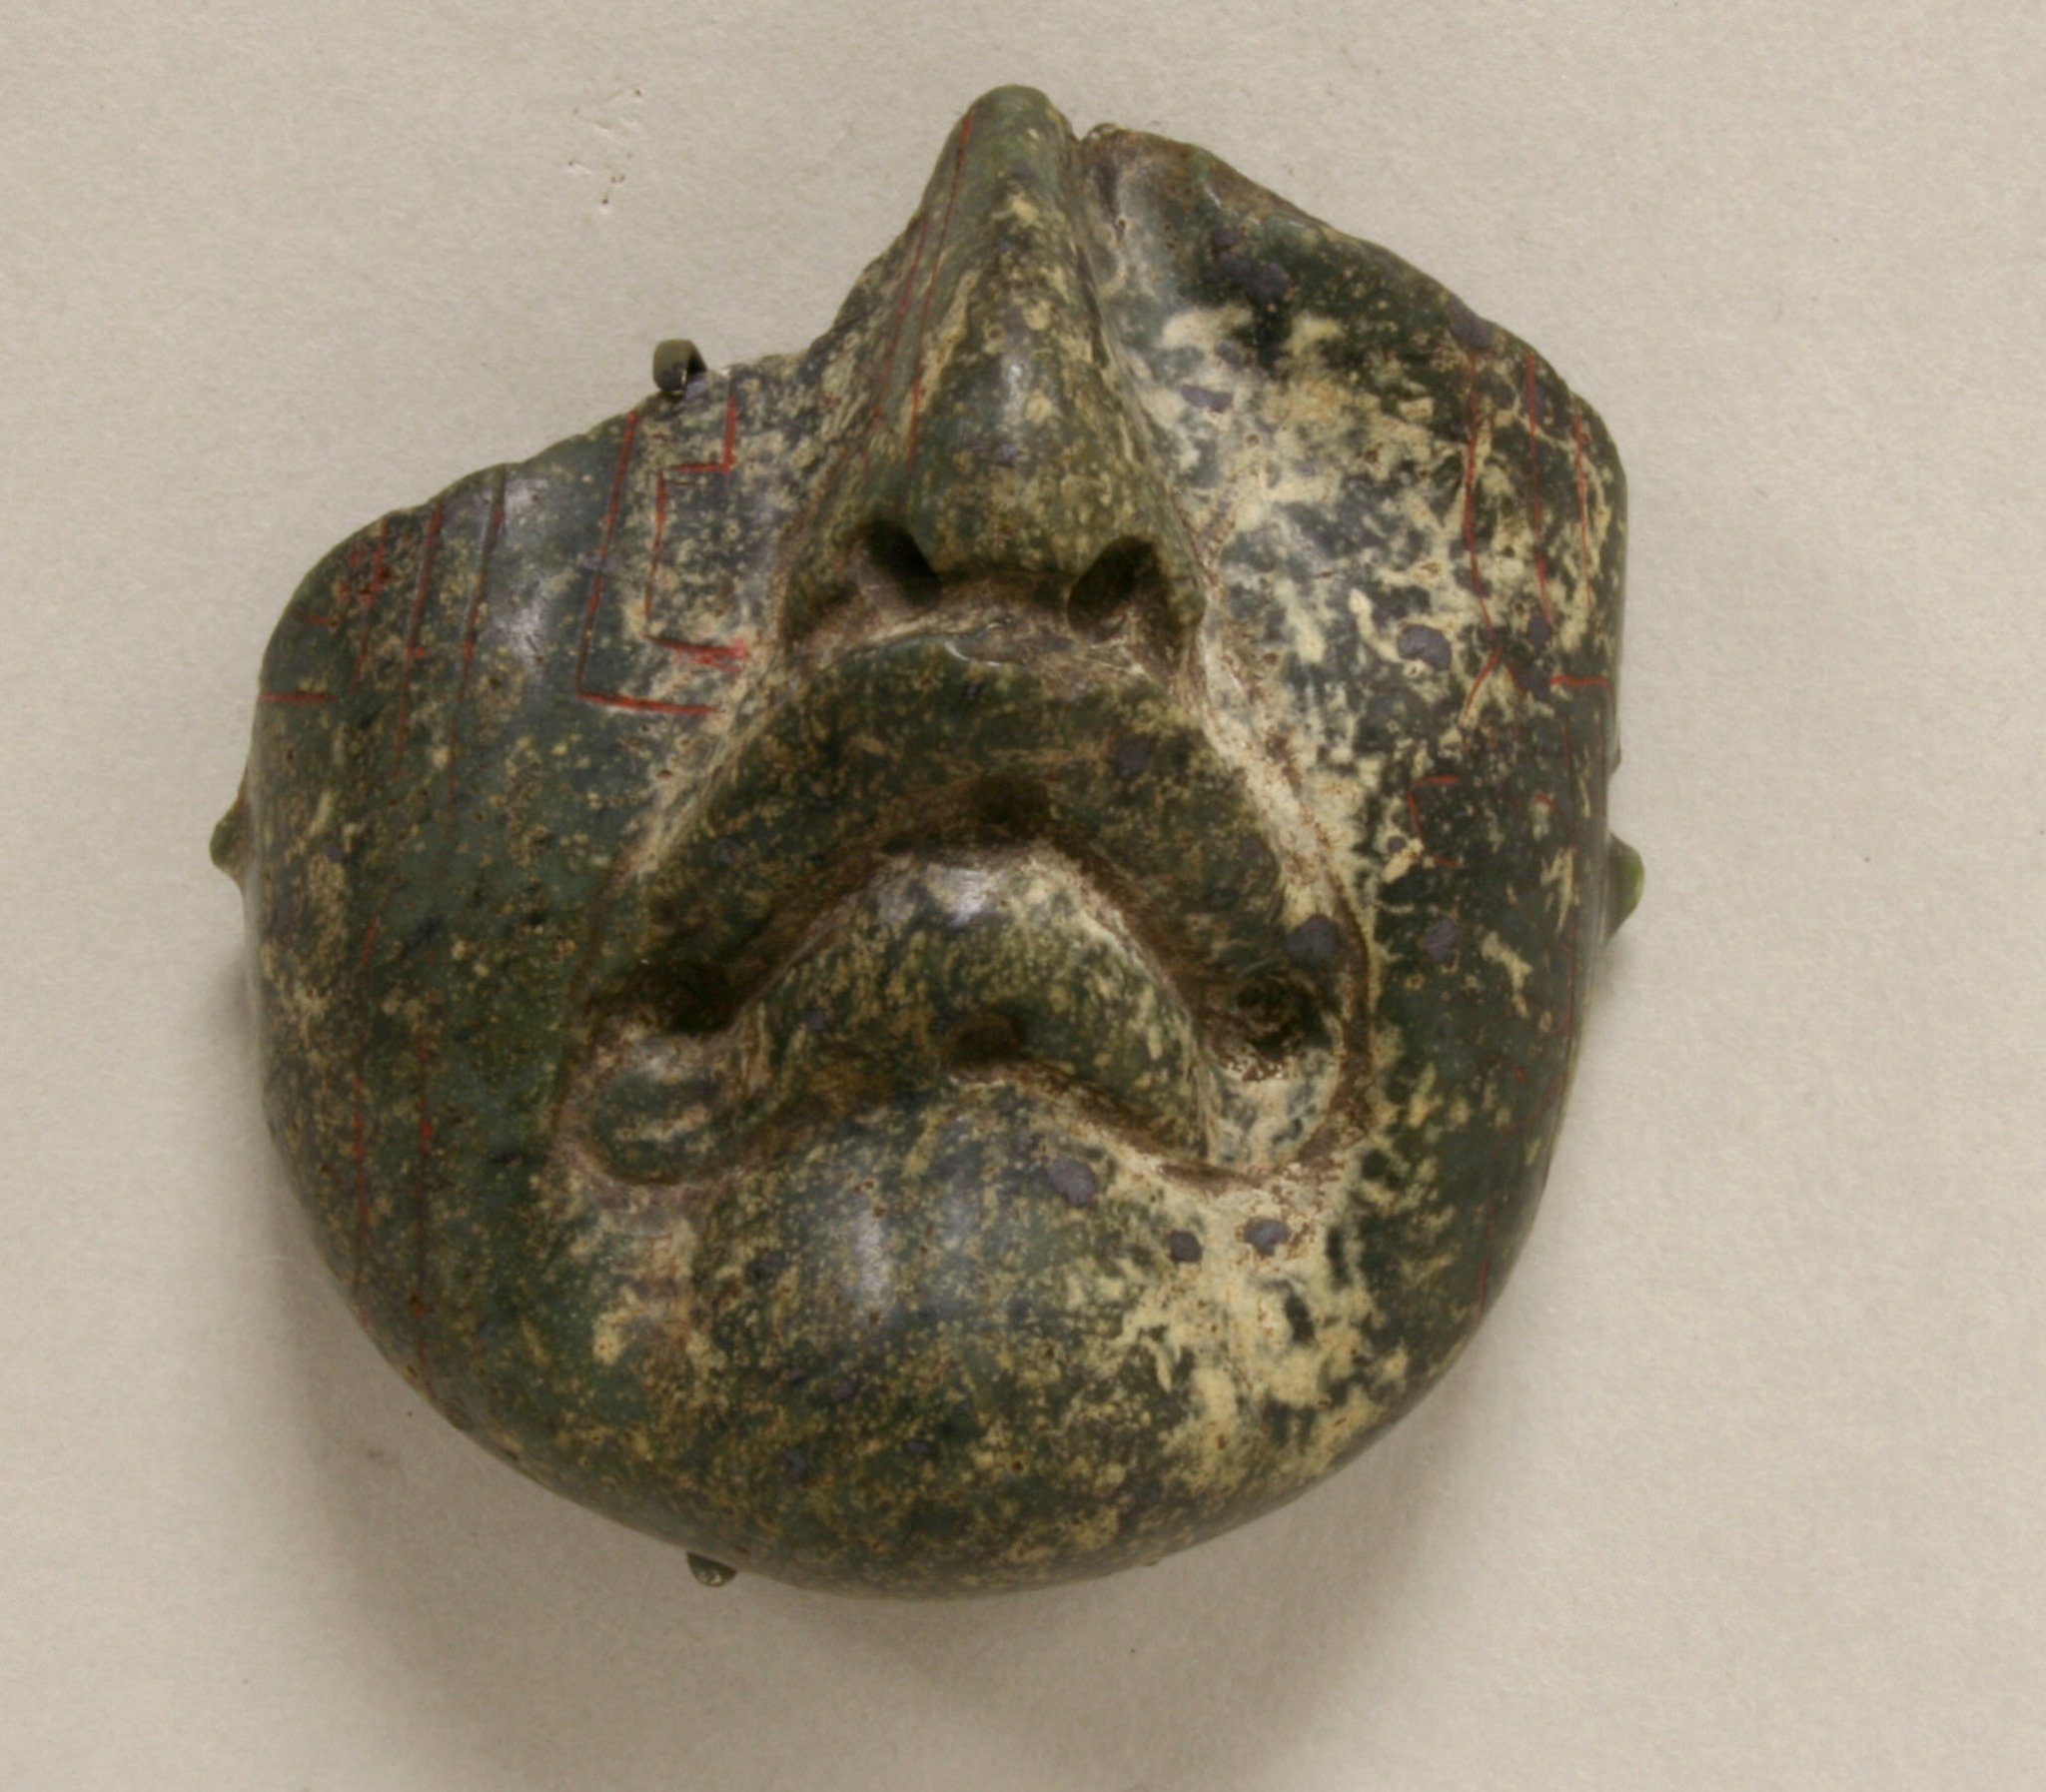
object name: mask fragment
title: Mask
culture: olmec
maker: olmec artist(s)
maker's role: artist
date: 1000-400 BCE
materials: stone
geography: mexico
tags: faces